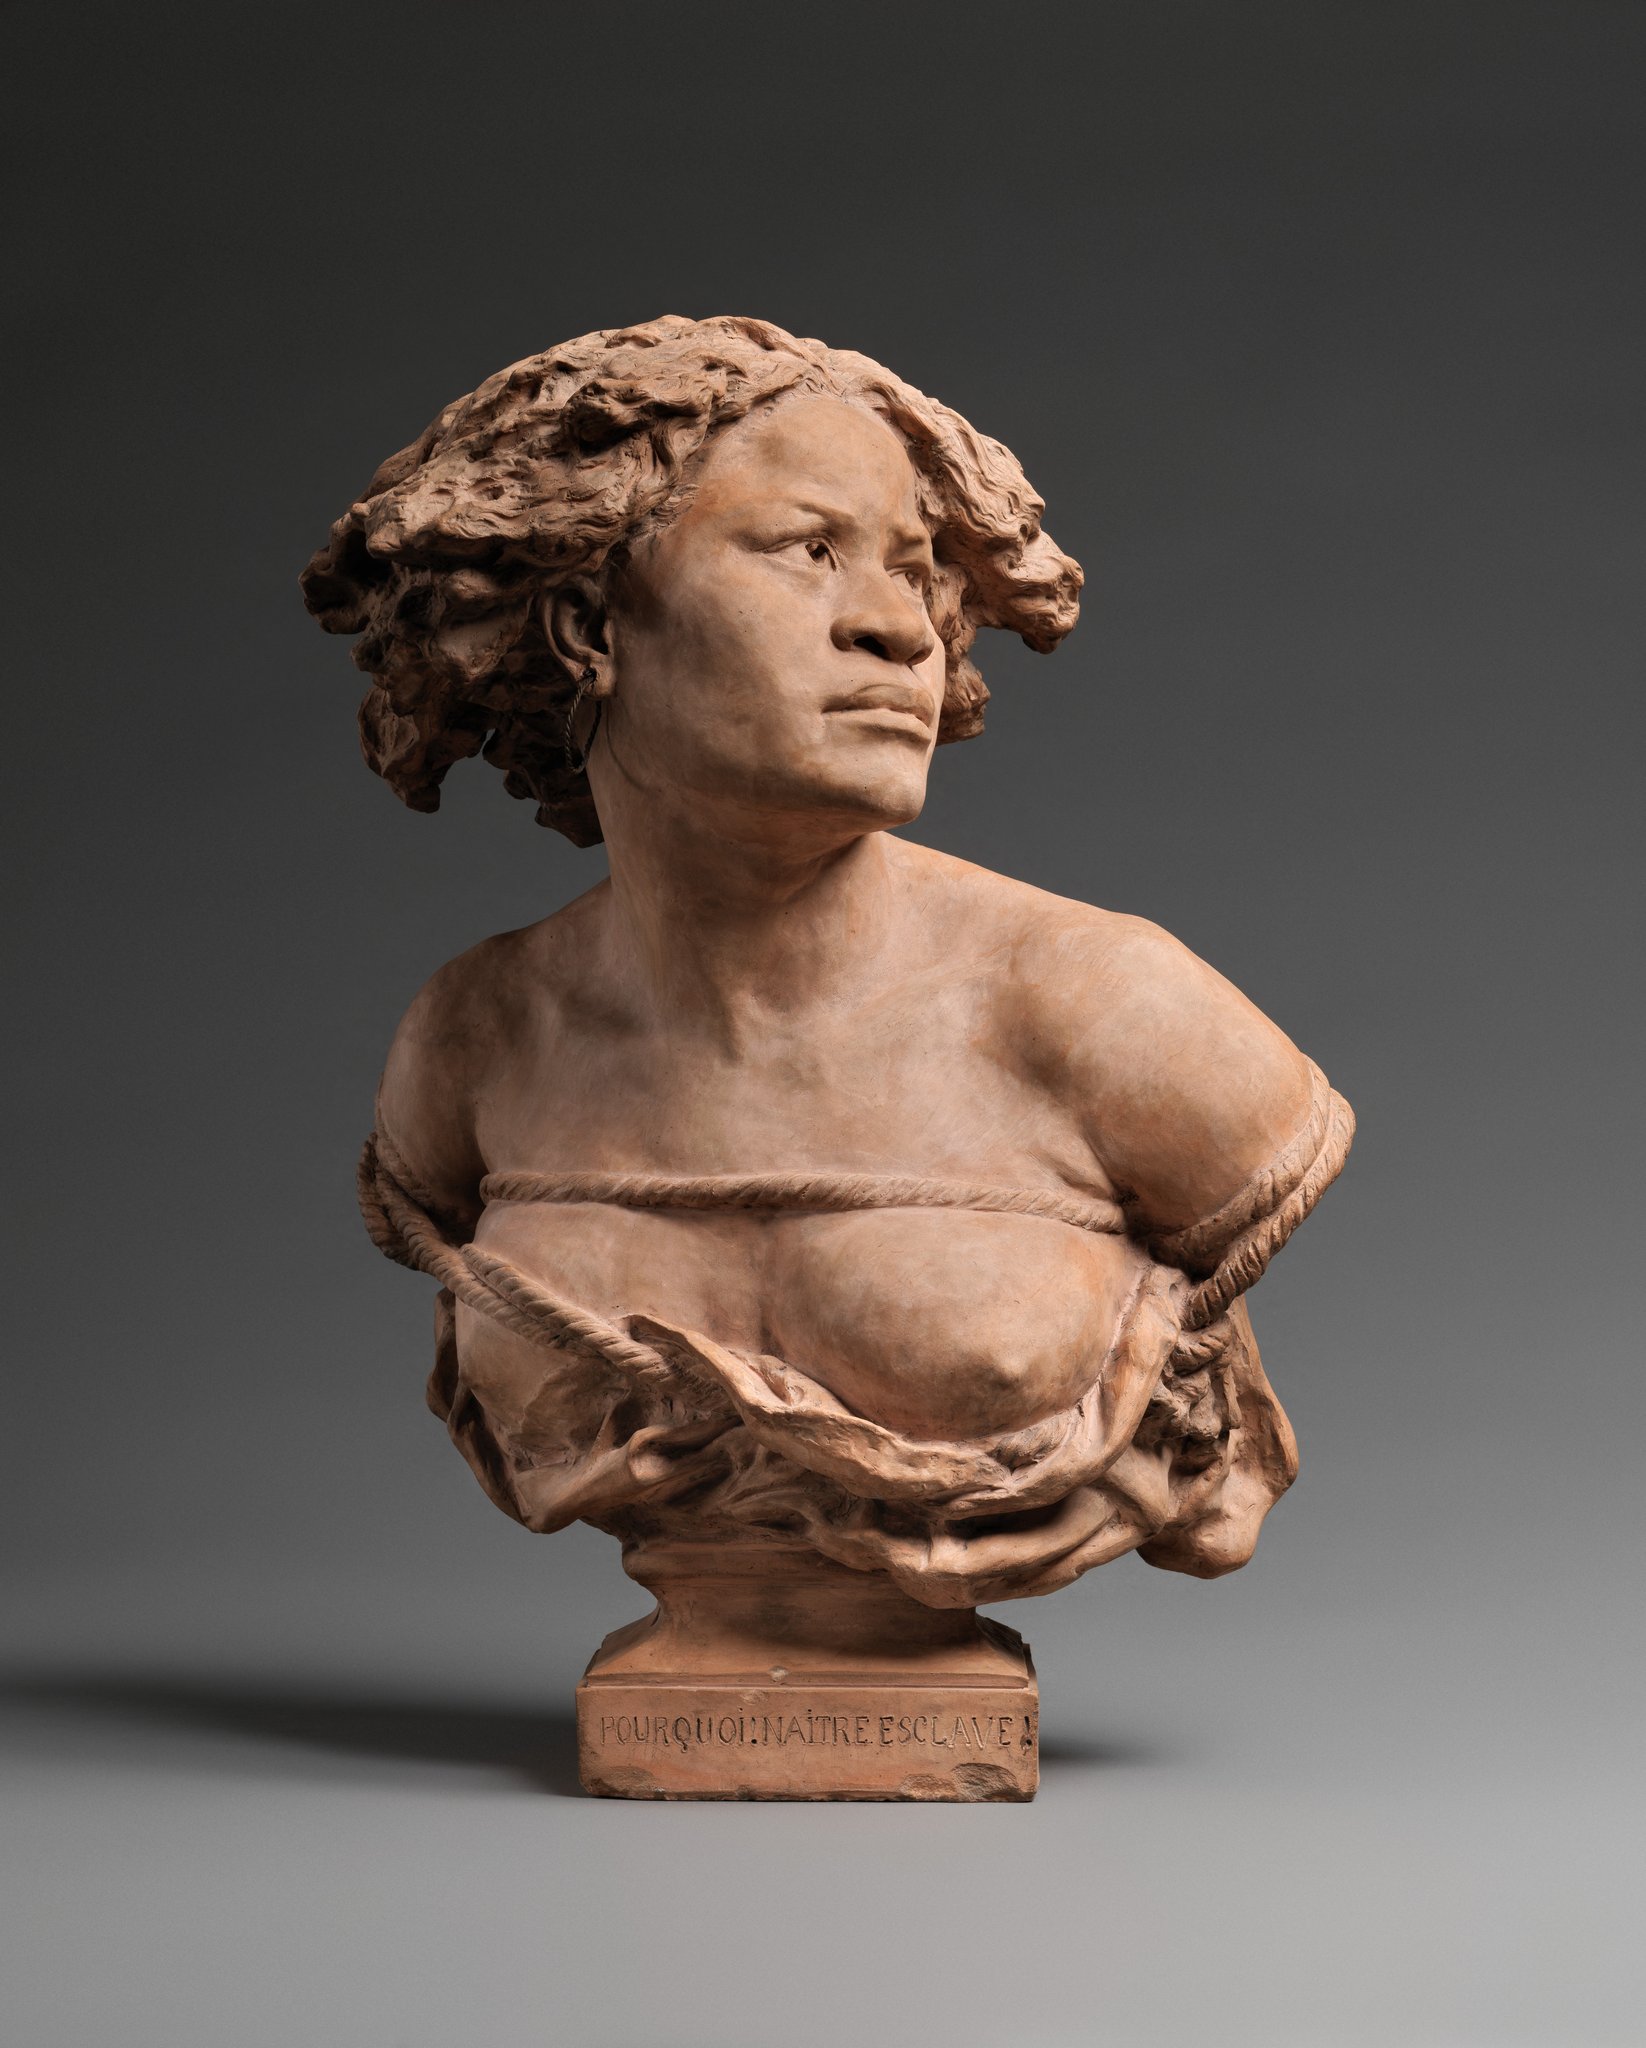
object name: bust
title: Why Born Enslaved!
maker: jean-baptiste carpeaux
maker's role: artist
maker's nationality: french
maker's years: 1827-1875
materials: terracotta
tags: female nudes